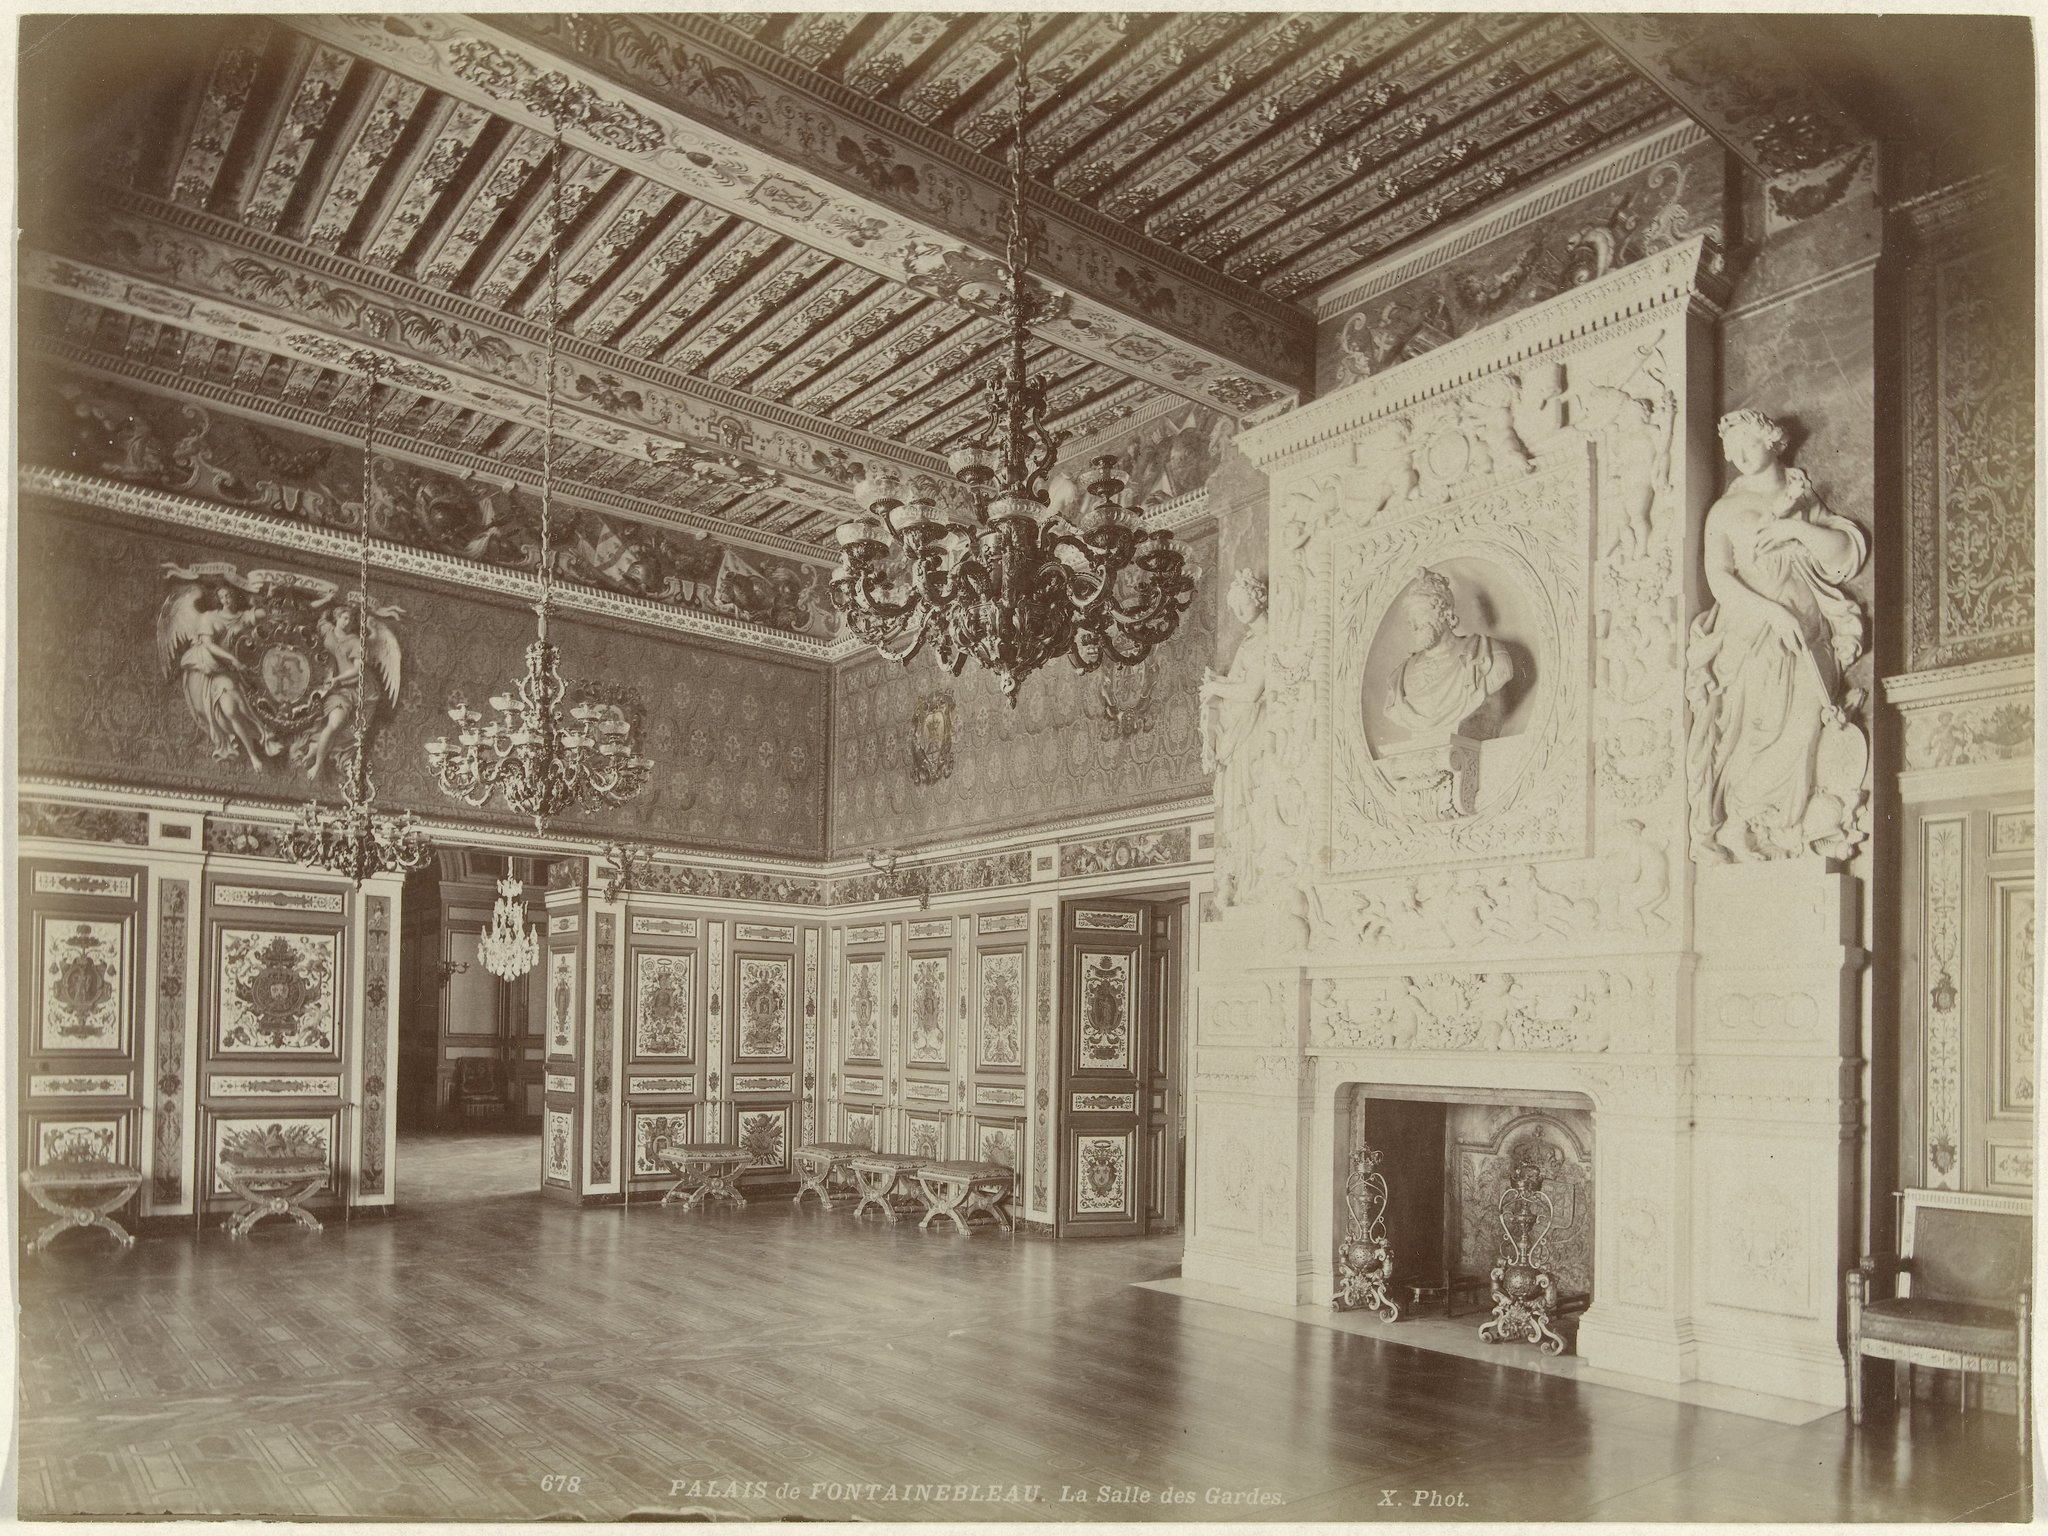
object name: photograph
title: Salle des Gardes in het kasteel van Fontainebleau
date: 1887-1900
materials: paper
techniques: albumen print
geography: fontainebleau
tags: palace - aa - civic architecture: inside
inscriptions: inscription: ‘678 Palais de Fontainebleau. La Salle des Gardes. X. Phot.’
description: Tussen 1887 en ca. 1900 werkten Neurdein frères onder andere onder de naam 'X phot.'.